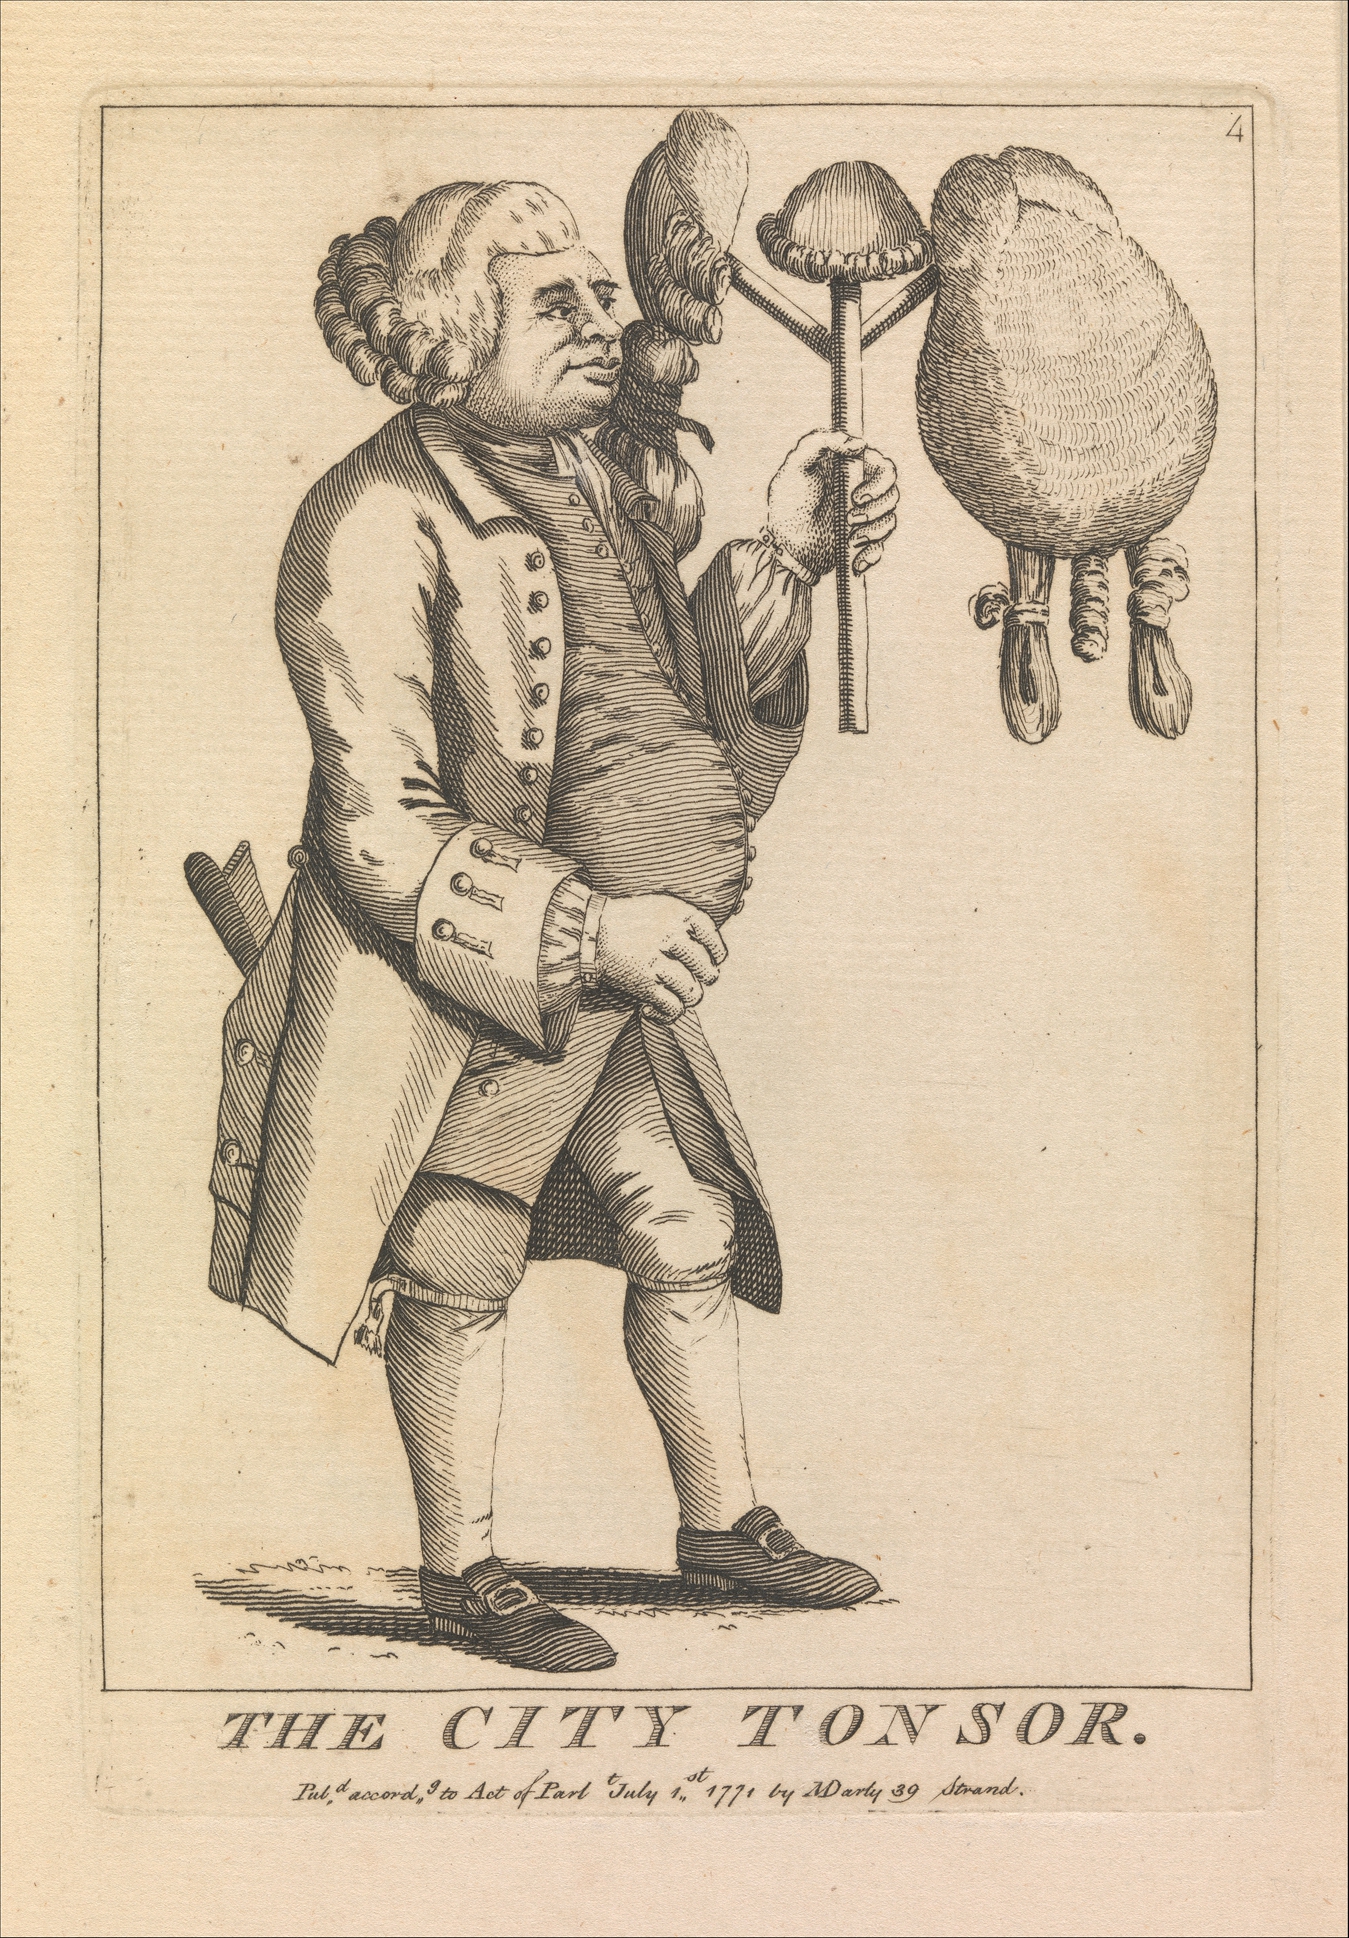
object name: print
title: The City Tonsor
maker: matthias darly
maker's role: publisher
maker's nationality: british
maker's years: 1720-1780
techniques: etching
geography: london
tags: men,wigs